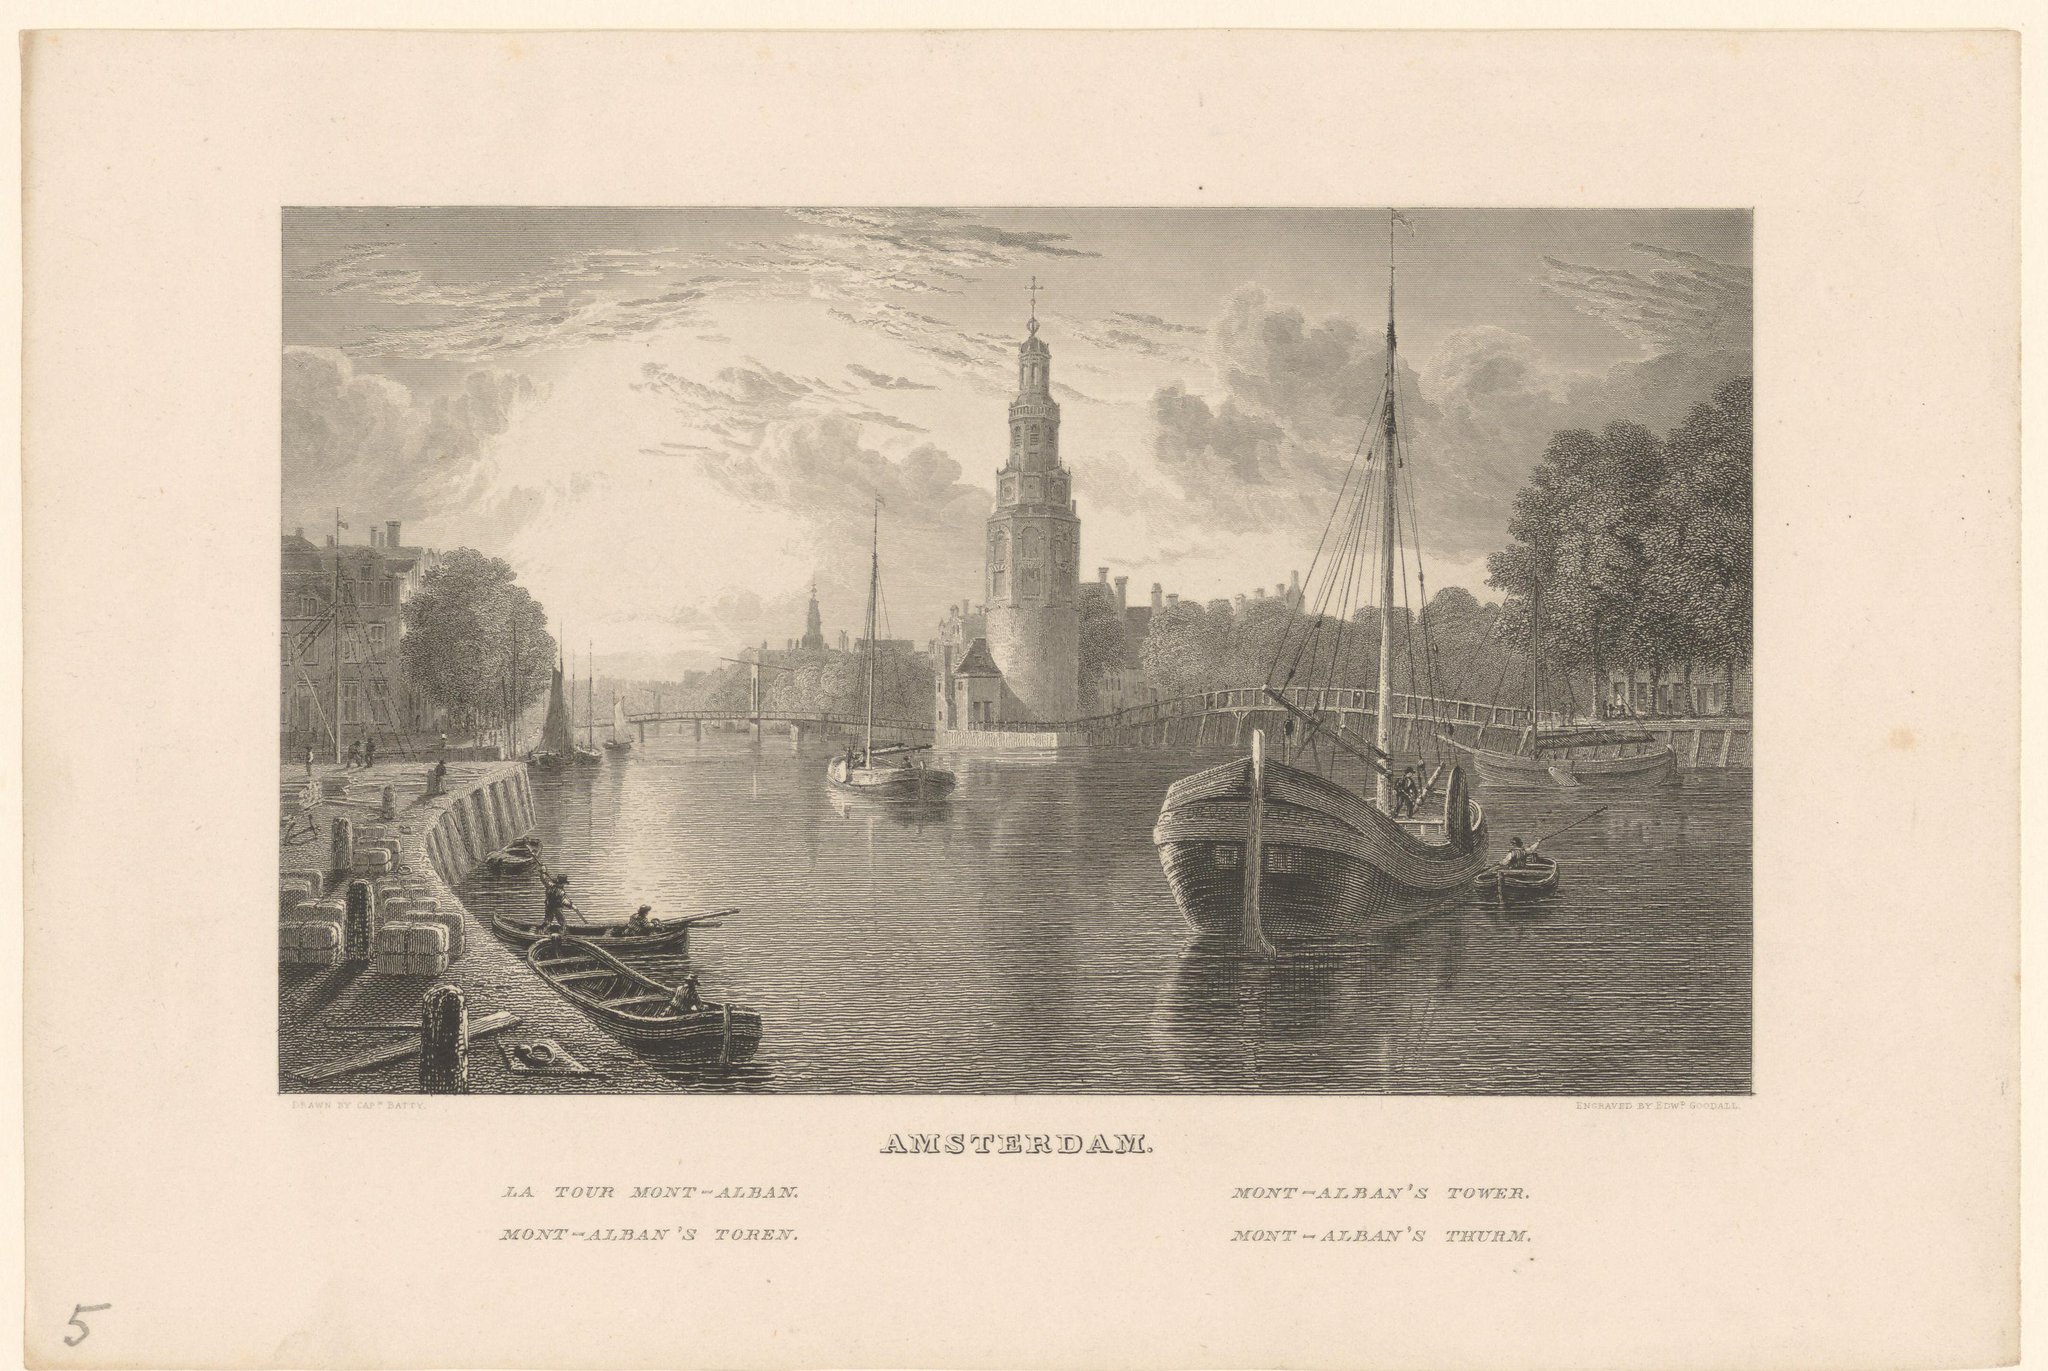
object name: print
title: La Tour Mont-Alban / Mont-Alban's Toren / Mont-Alban's Tower / Mont-Alban's Thurm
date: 1805-1825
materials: paper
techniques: engraving, etching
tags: tower, clock tower ~ monumental adornment - ii - ideal city (+ city(-scape) with figures, staffage), amsterdam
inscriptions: collector's mark: Lugt 2228